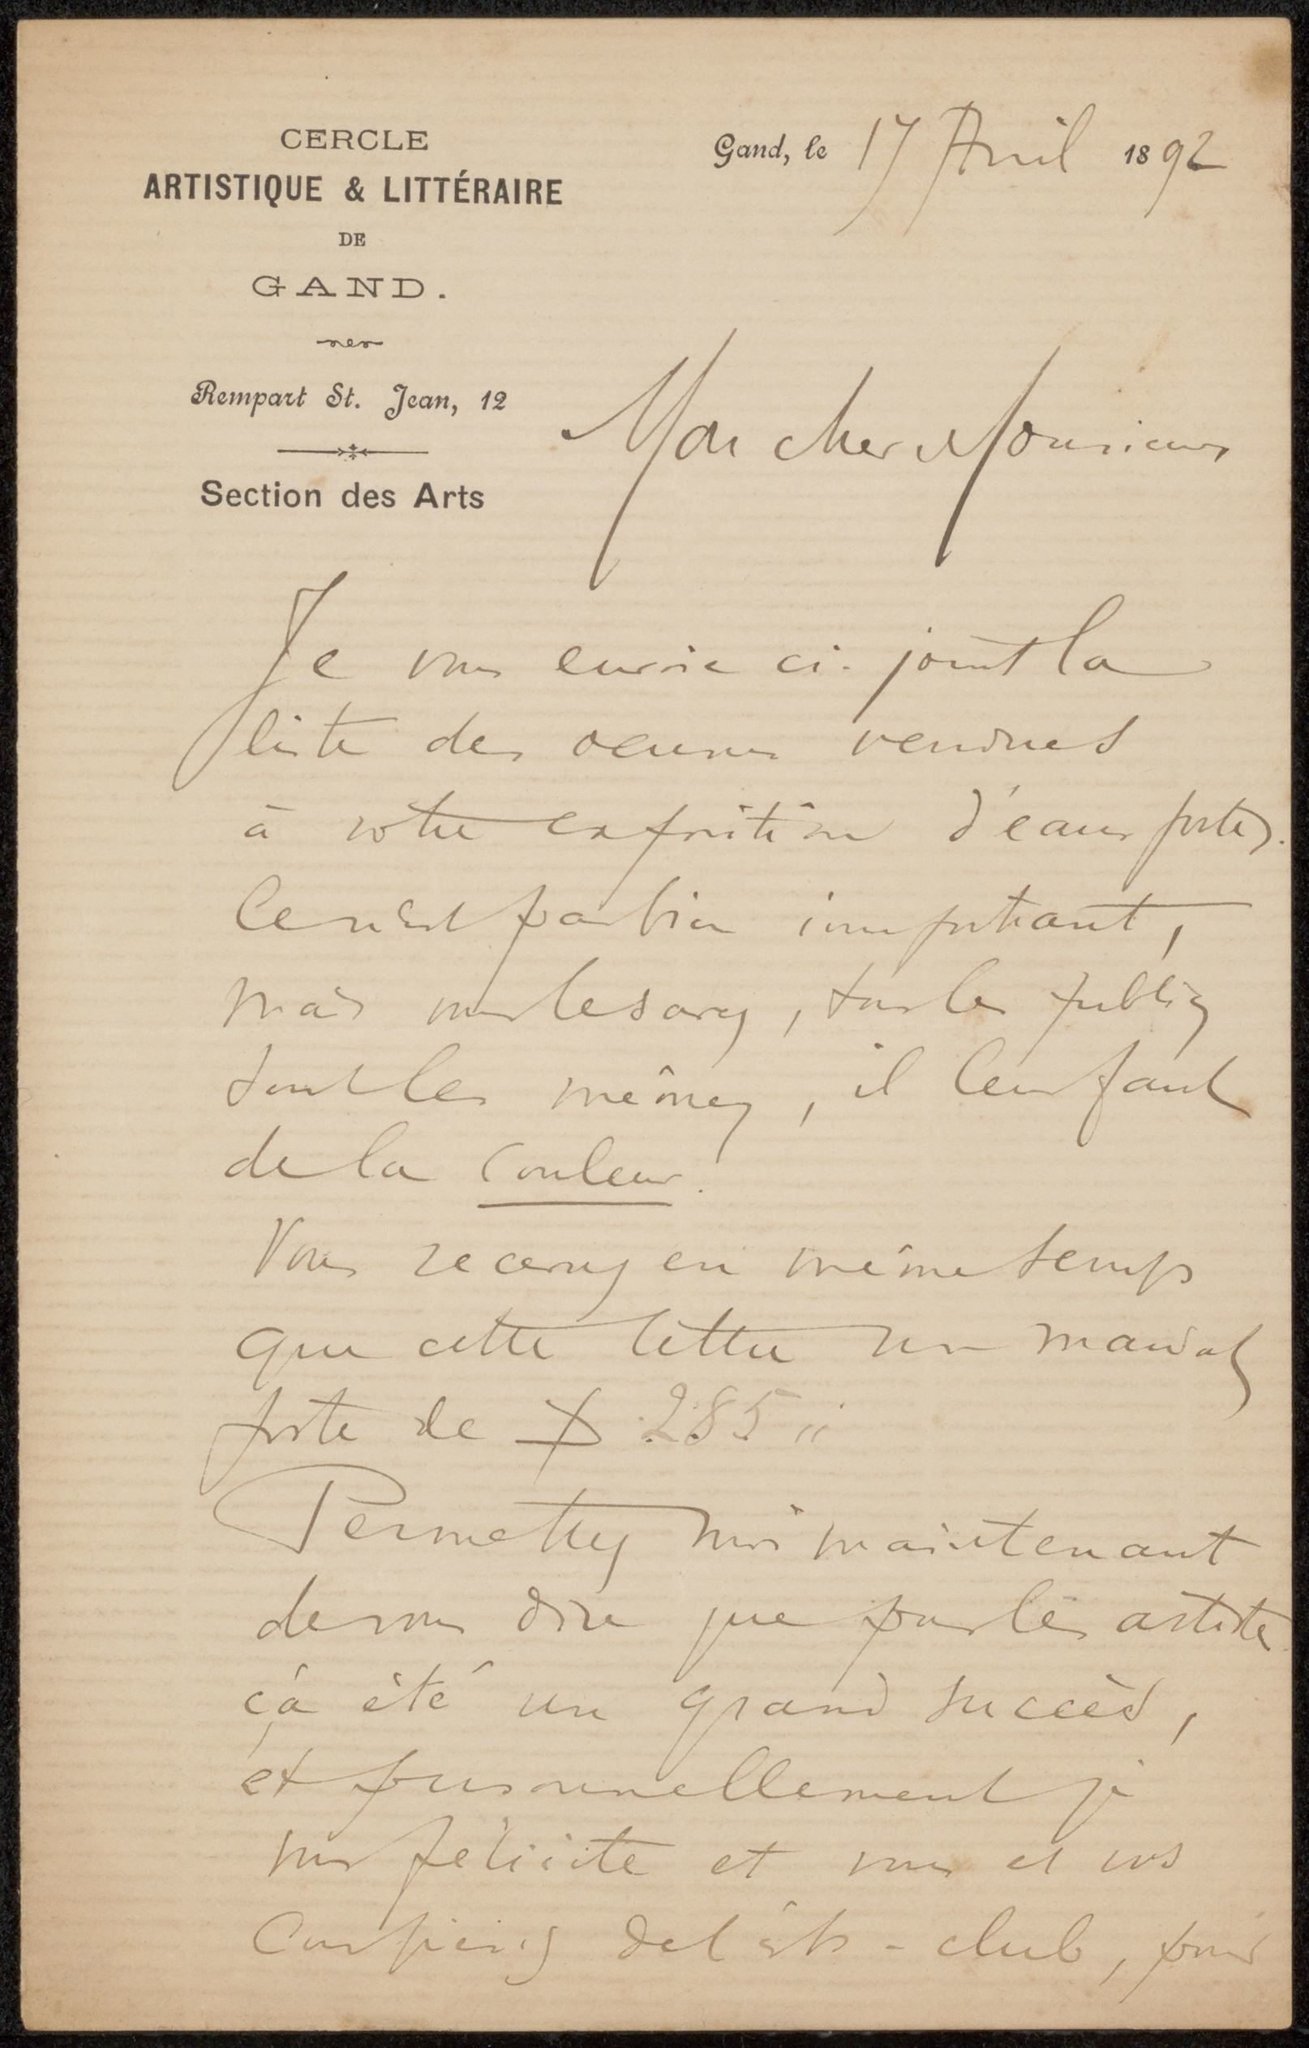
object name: letter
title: Brief aan Philip Zilcken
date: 1892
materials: ink, paper, pencil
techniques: pen, printing, writing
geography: ghent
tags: the hague, painter, philip zilcken, the graphic arts, temporary exhibition, 'salon'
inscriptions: collector's mark: ‘RPK’